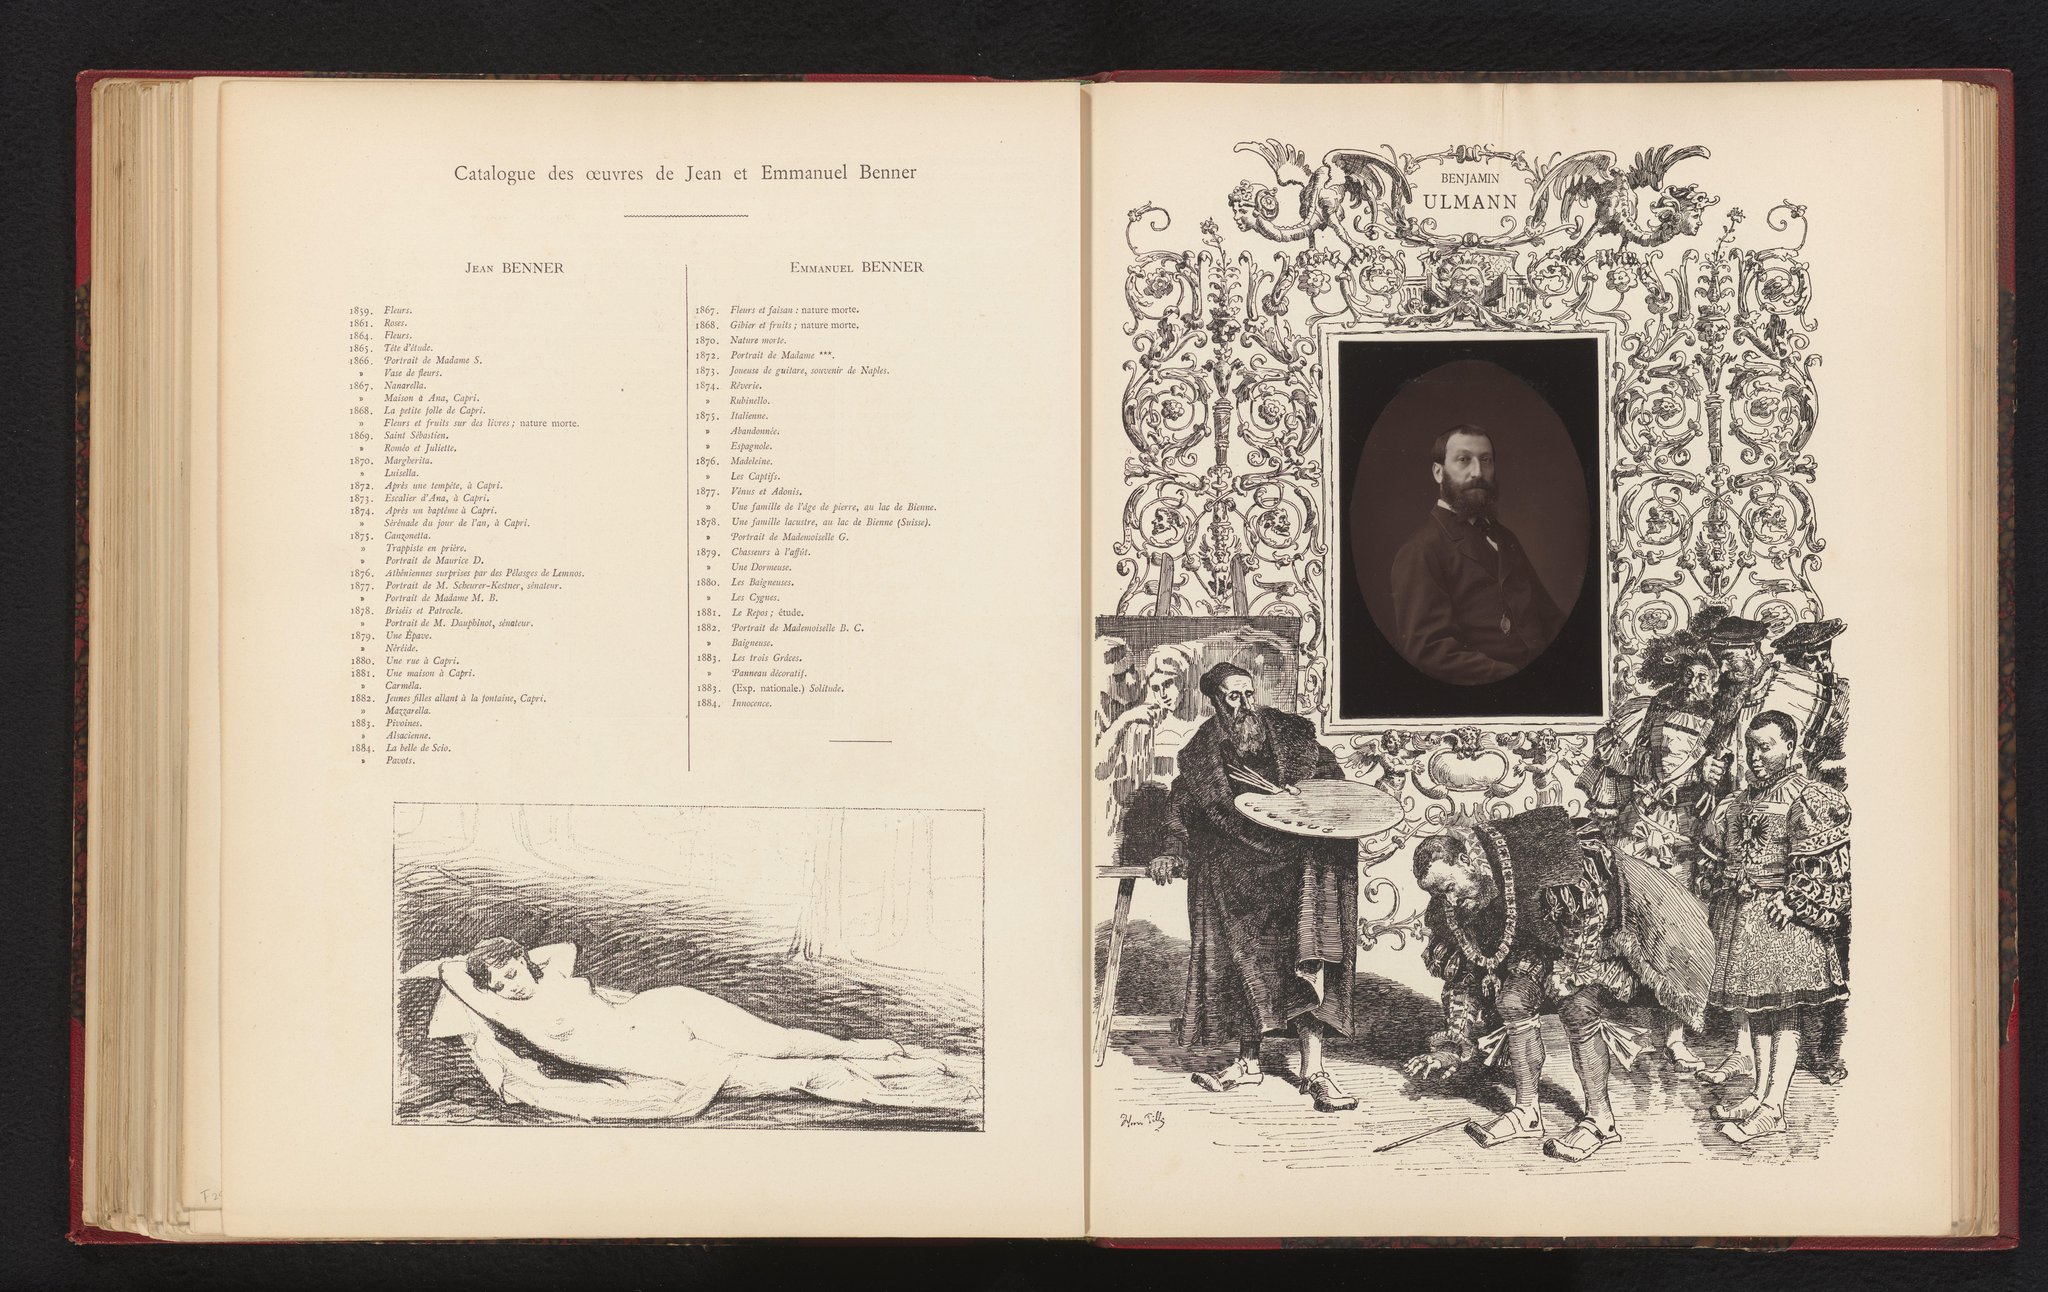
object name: photomechanical print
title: Benjamin Ulmann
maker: Anonymous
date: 1879-1884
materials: paper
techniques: woodburytype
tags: painter, benjamin ulmann, historical persons